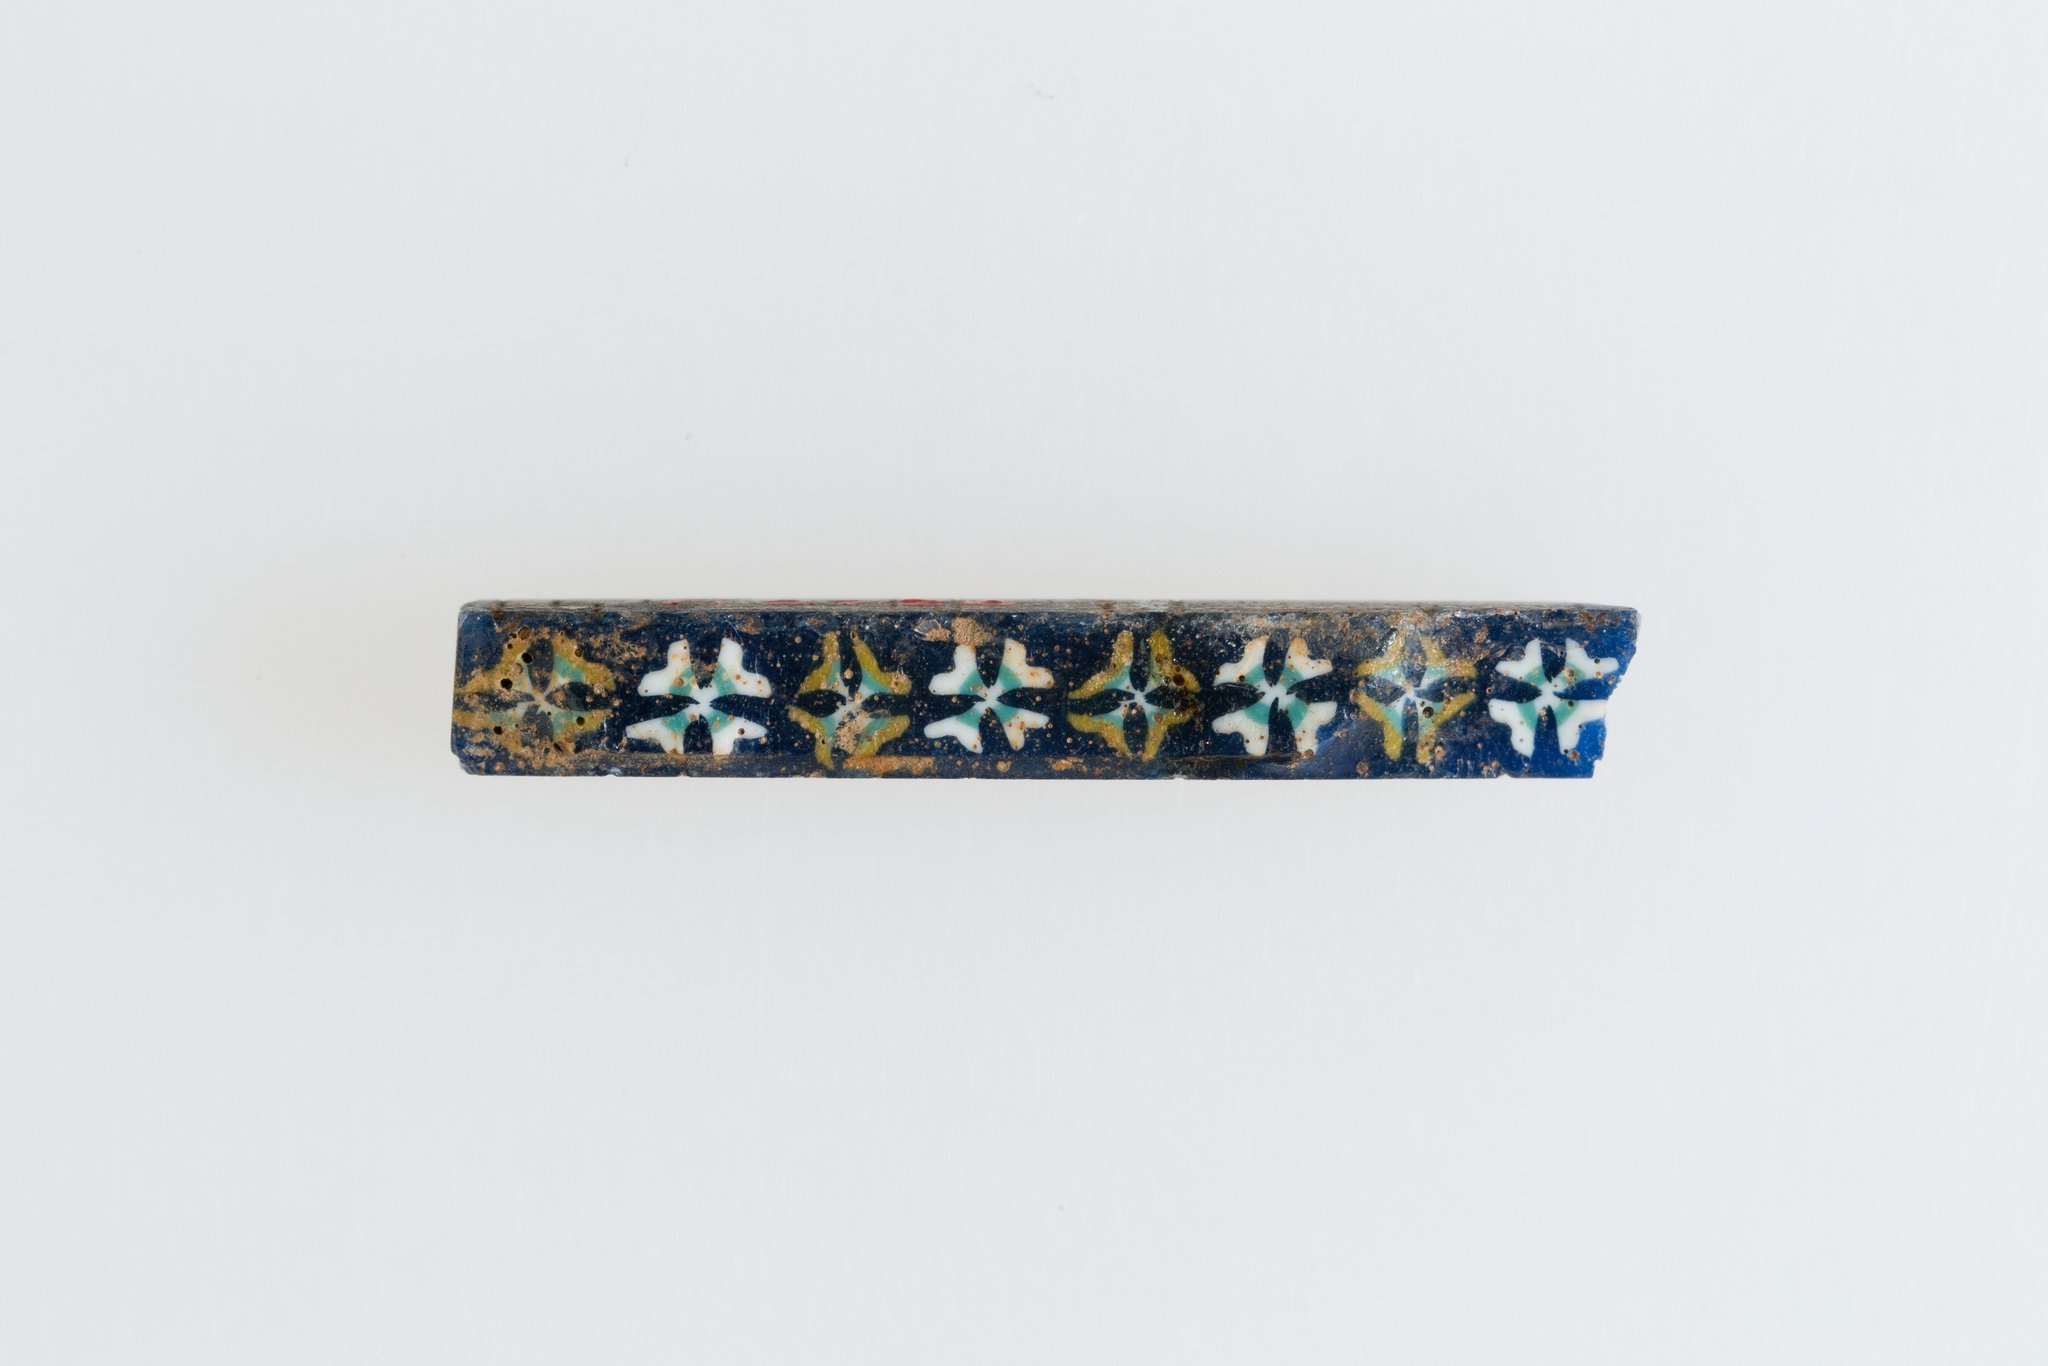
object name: inlay fragment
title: Inlay with row of rosettes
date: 200 BCE-100 CE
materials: glass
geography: egypt